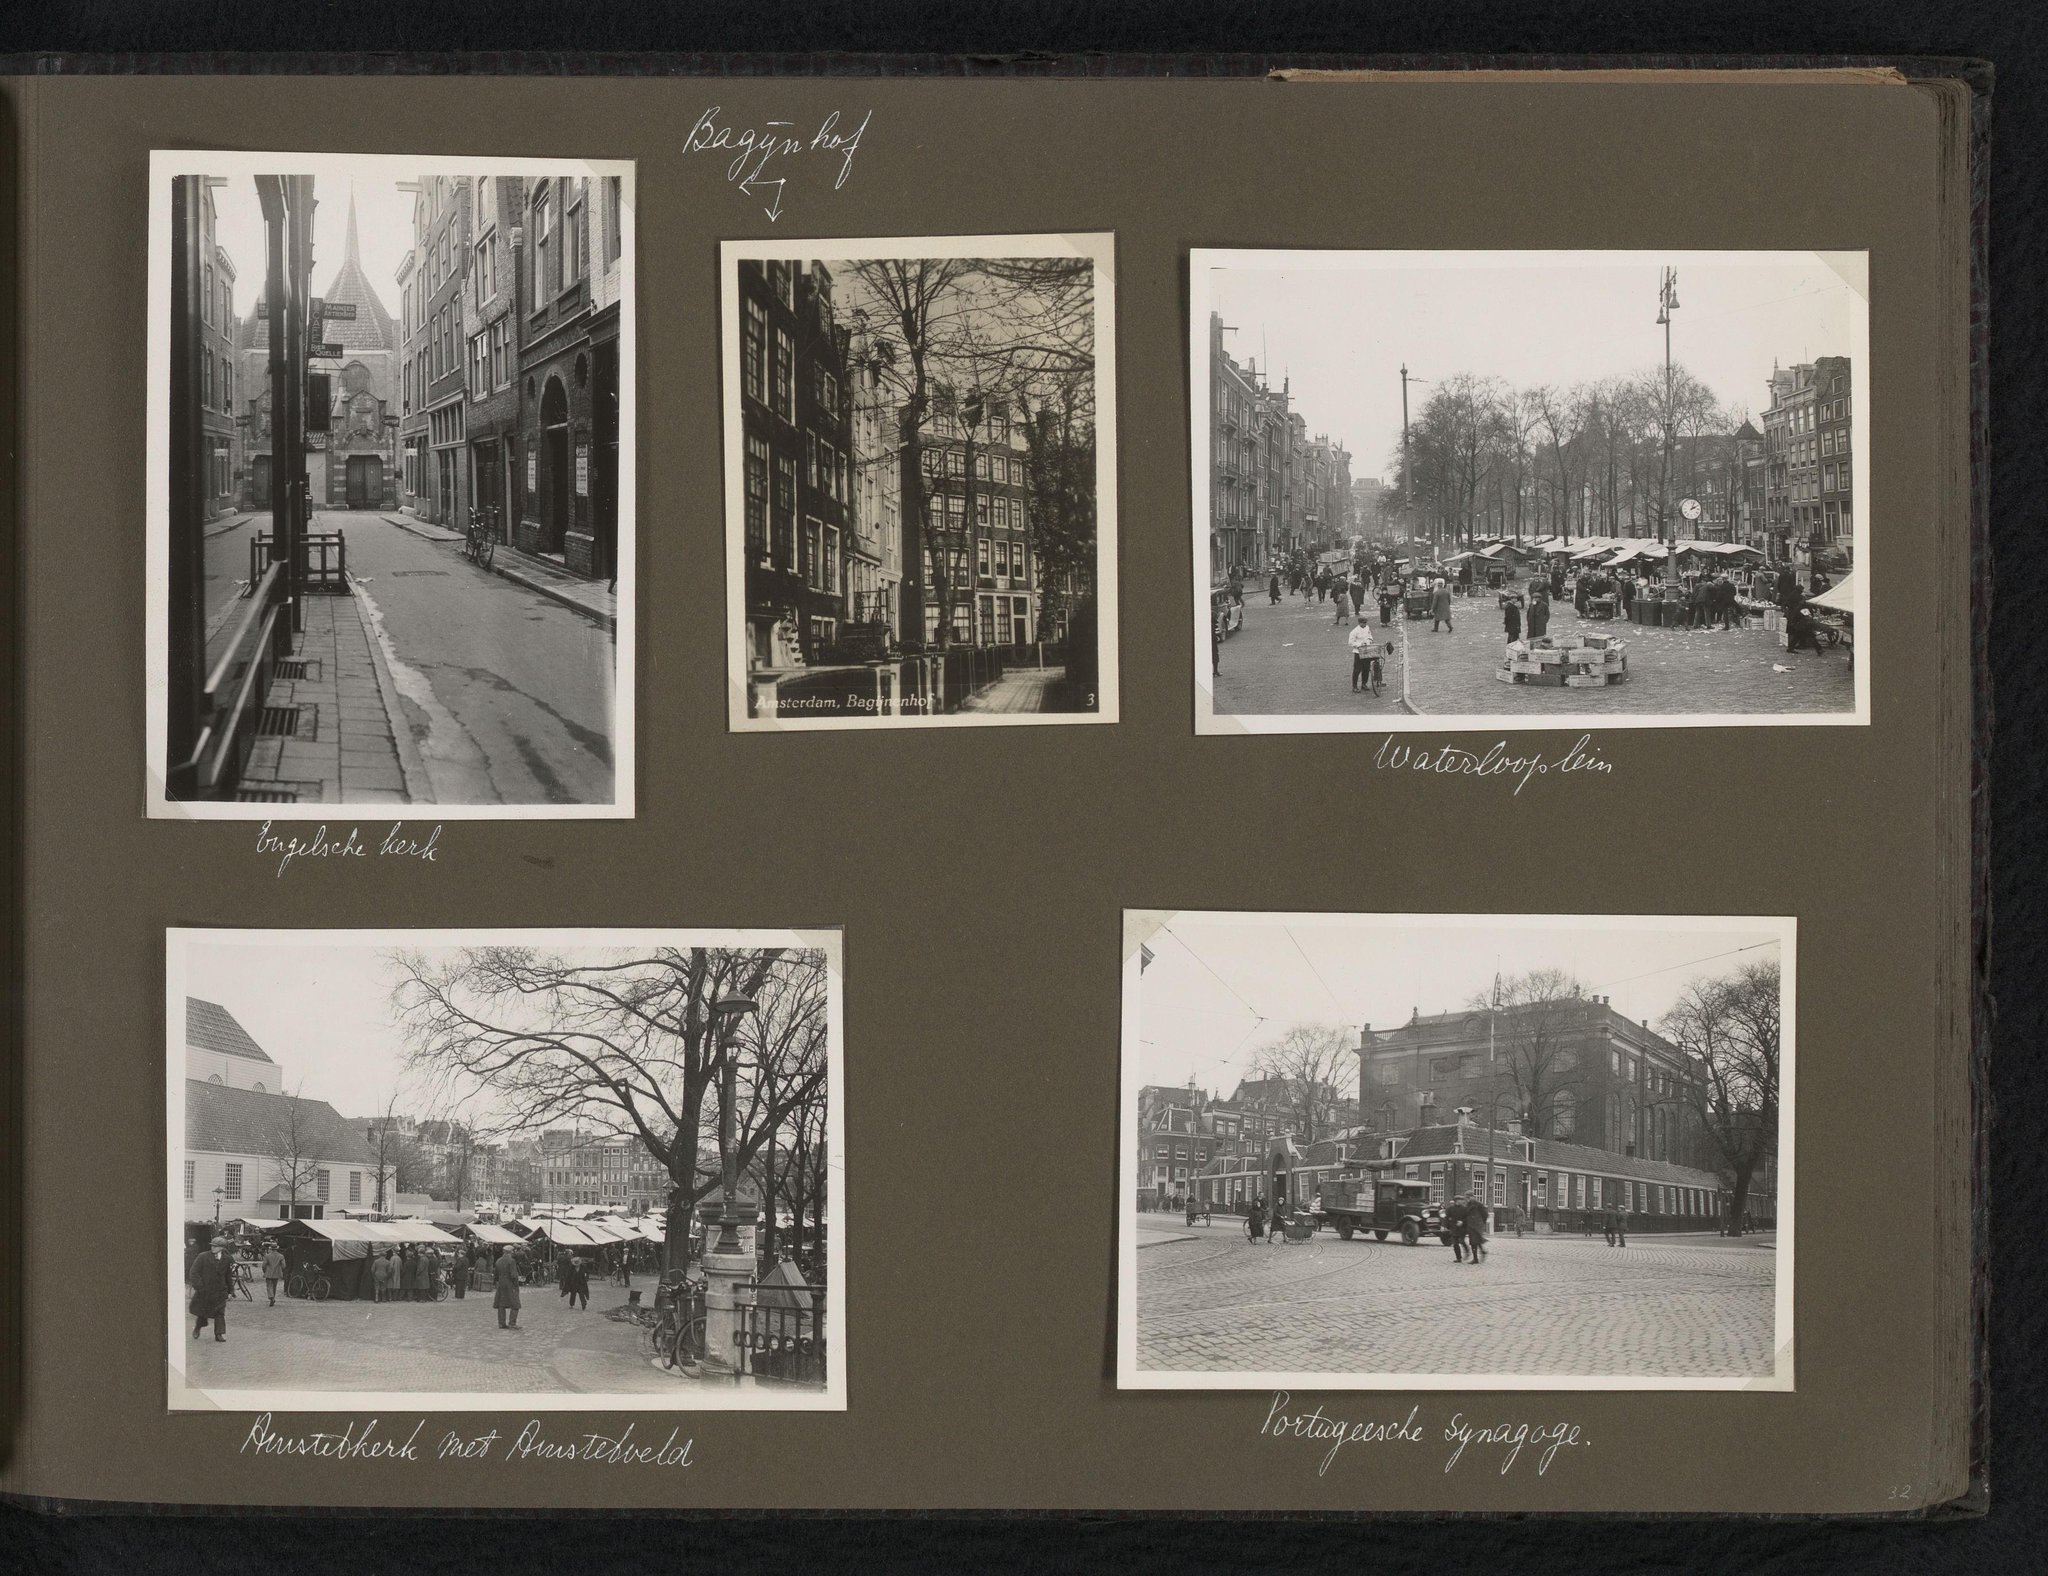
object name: album leaf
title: Vijf foto's van het Begijnhof, Waterlooplein, Amstelveld en de Portugese Synagoge in Amsterdam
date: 1930-1931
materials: paper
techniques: gelatin silver print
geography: amsterdam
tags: square, place, circus, etc., the synagogue (as building and place of worship ~ jewish religion), church (exterior), market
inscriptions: inscription: ‘Amstelkerk met Amstelveld’, inscription: ‘Begijnhof’, inscription: ‘Engelsche kerk’, inscription: ‘Portugeesche Synagoge’, inscription: ‘Waterlooplein’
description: Deze foto's maken deel uit van een album.